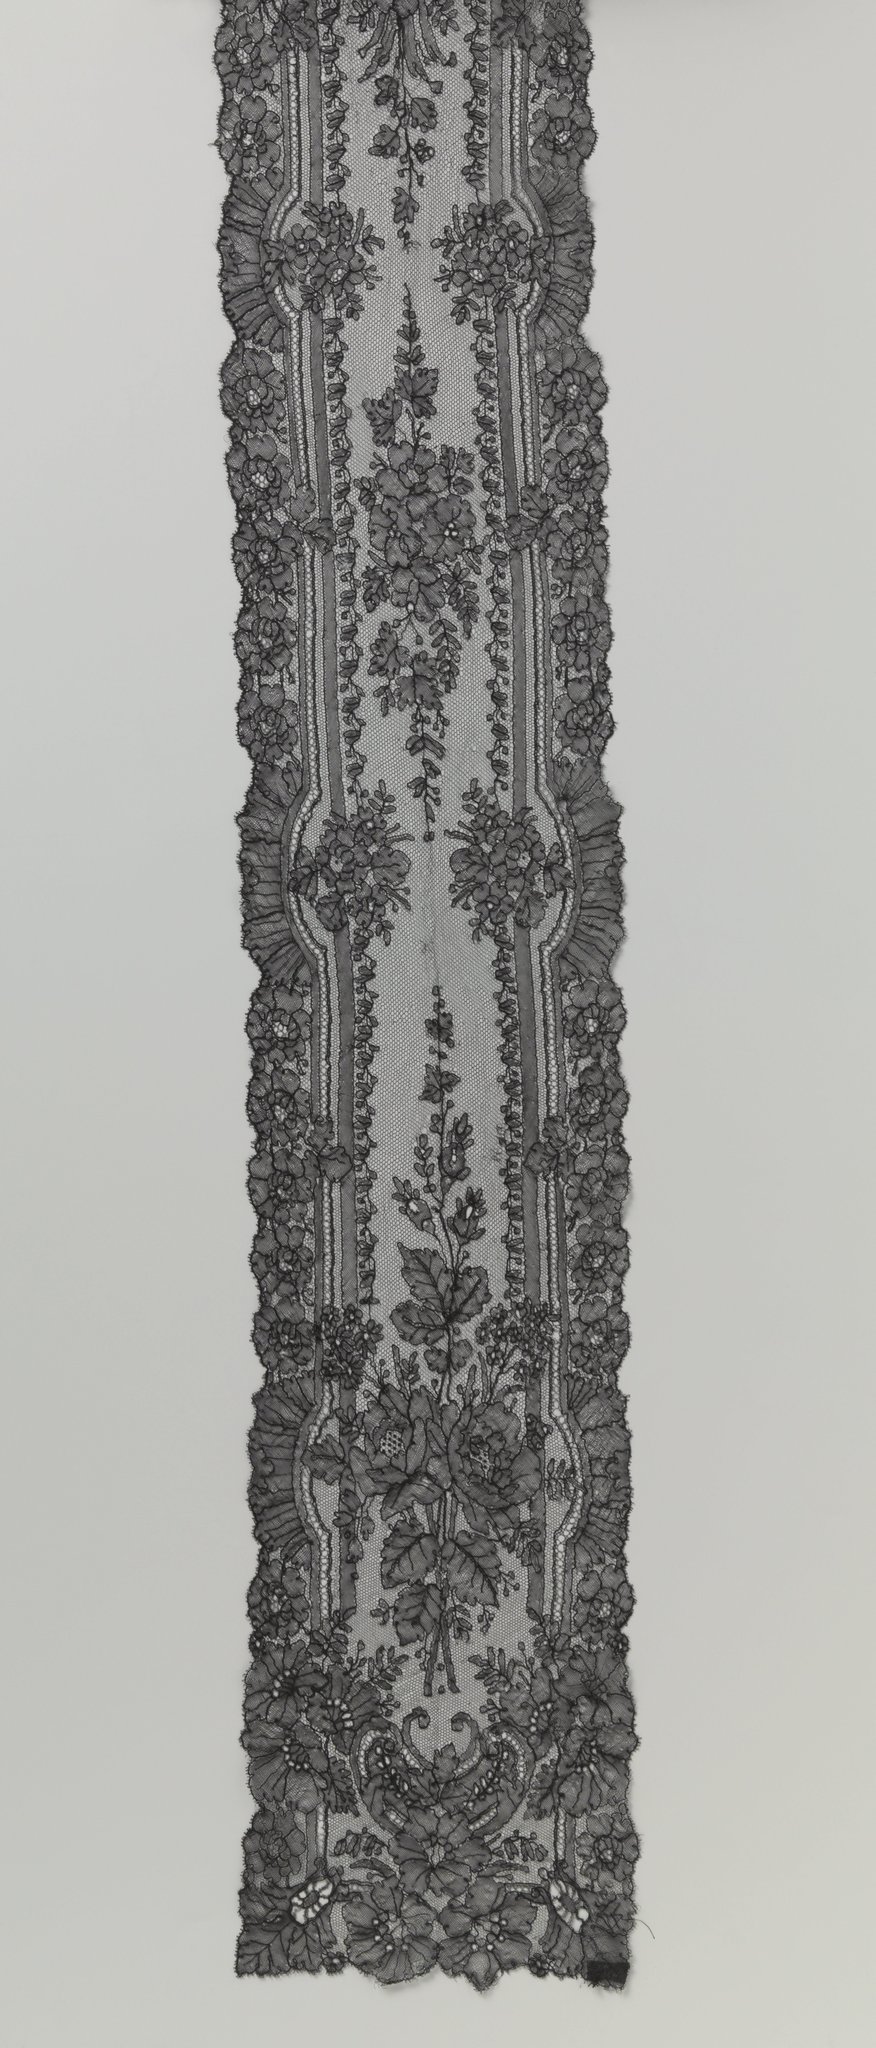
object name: lappet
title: Das of mutsenslip van kloskant met de Oost-Indische kers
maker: Anonymous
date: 1850-1880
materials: silk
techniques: lace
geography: bayeux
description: Das of barbe van zwarte kloskant: Chantilly-kant. Gerekt rechthoekig van vorm. Tweezijdig symmetrisch dessin. Op een mazenfond staan, verspreid uit elkaar, toefjes rankonkels(?) en rozen met spitse uitlopers naar beide zijden. Rondom lopen een brede rechte profiellijst en verdubbelde smallere profiellijsten, die telkens een schulp vormen met uitstralende blaadjes. Aan de uiteinden staat een symmetrisch decor van een c-voluut, driemaal een toefje van drie 'Oost-Indische kers-kelkjes' en twee overhoekse ovaaltjes.